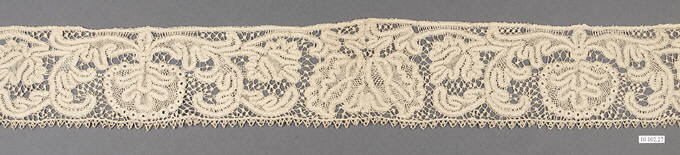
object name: edging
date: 1701-1800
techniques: lace